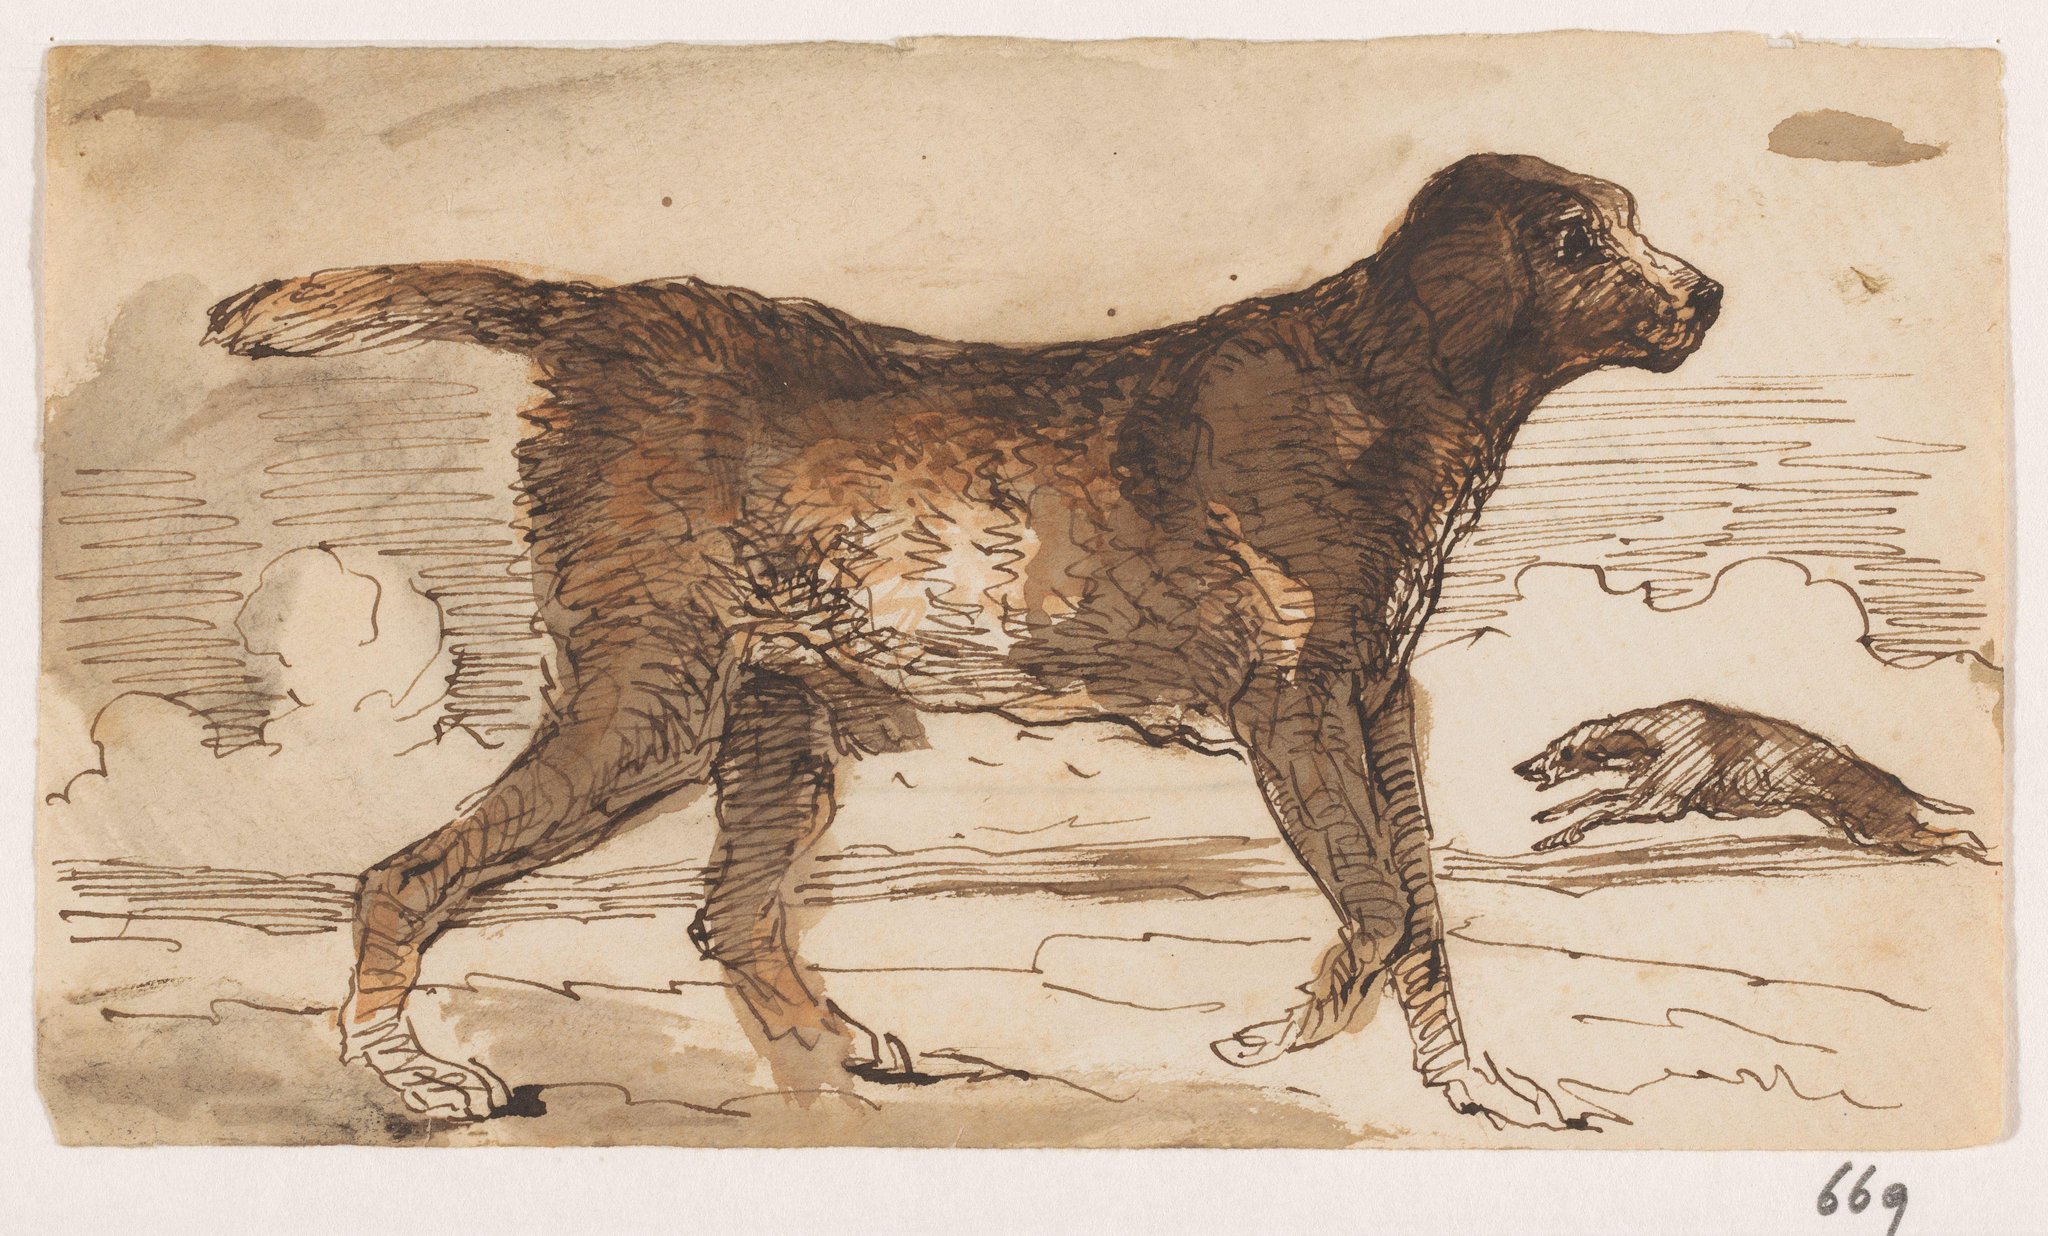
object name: drawing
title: Jachthond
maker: johannes tavenraat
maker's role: draughtsman, painter, print maker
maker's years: 1809-1881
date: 1840-1880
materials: ink, paper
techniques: brush, pen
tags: hunting dogs, dog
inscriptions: collector's mark: Lugt 2228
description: Jachthond. Getekend op de achterzijde van een deel van een envelop of brief gericht aan J. Tavenraat.